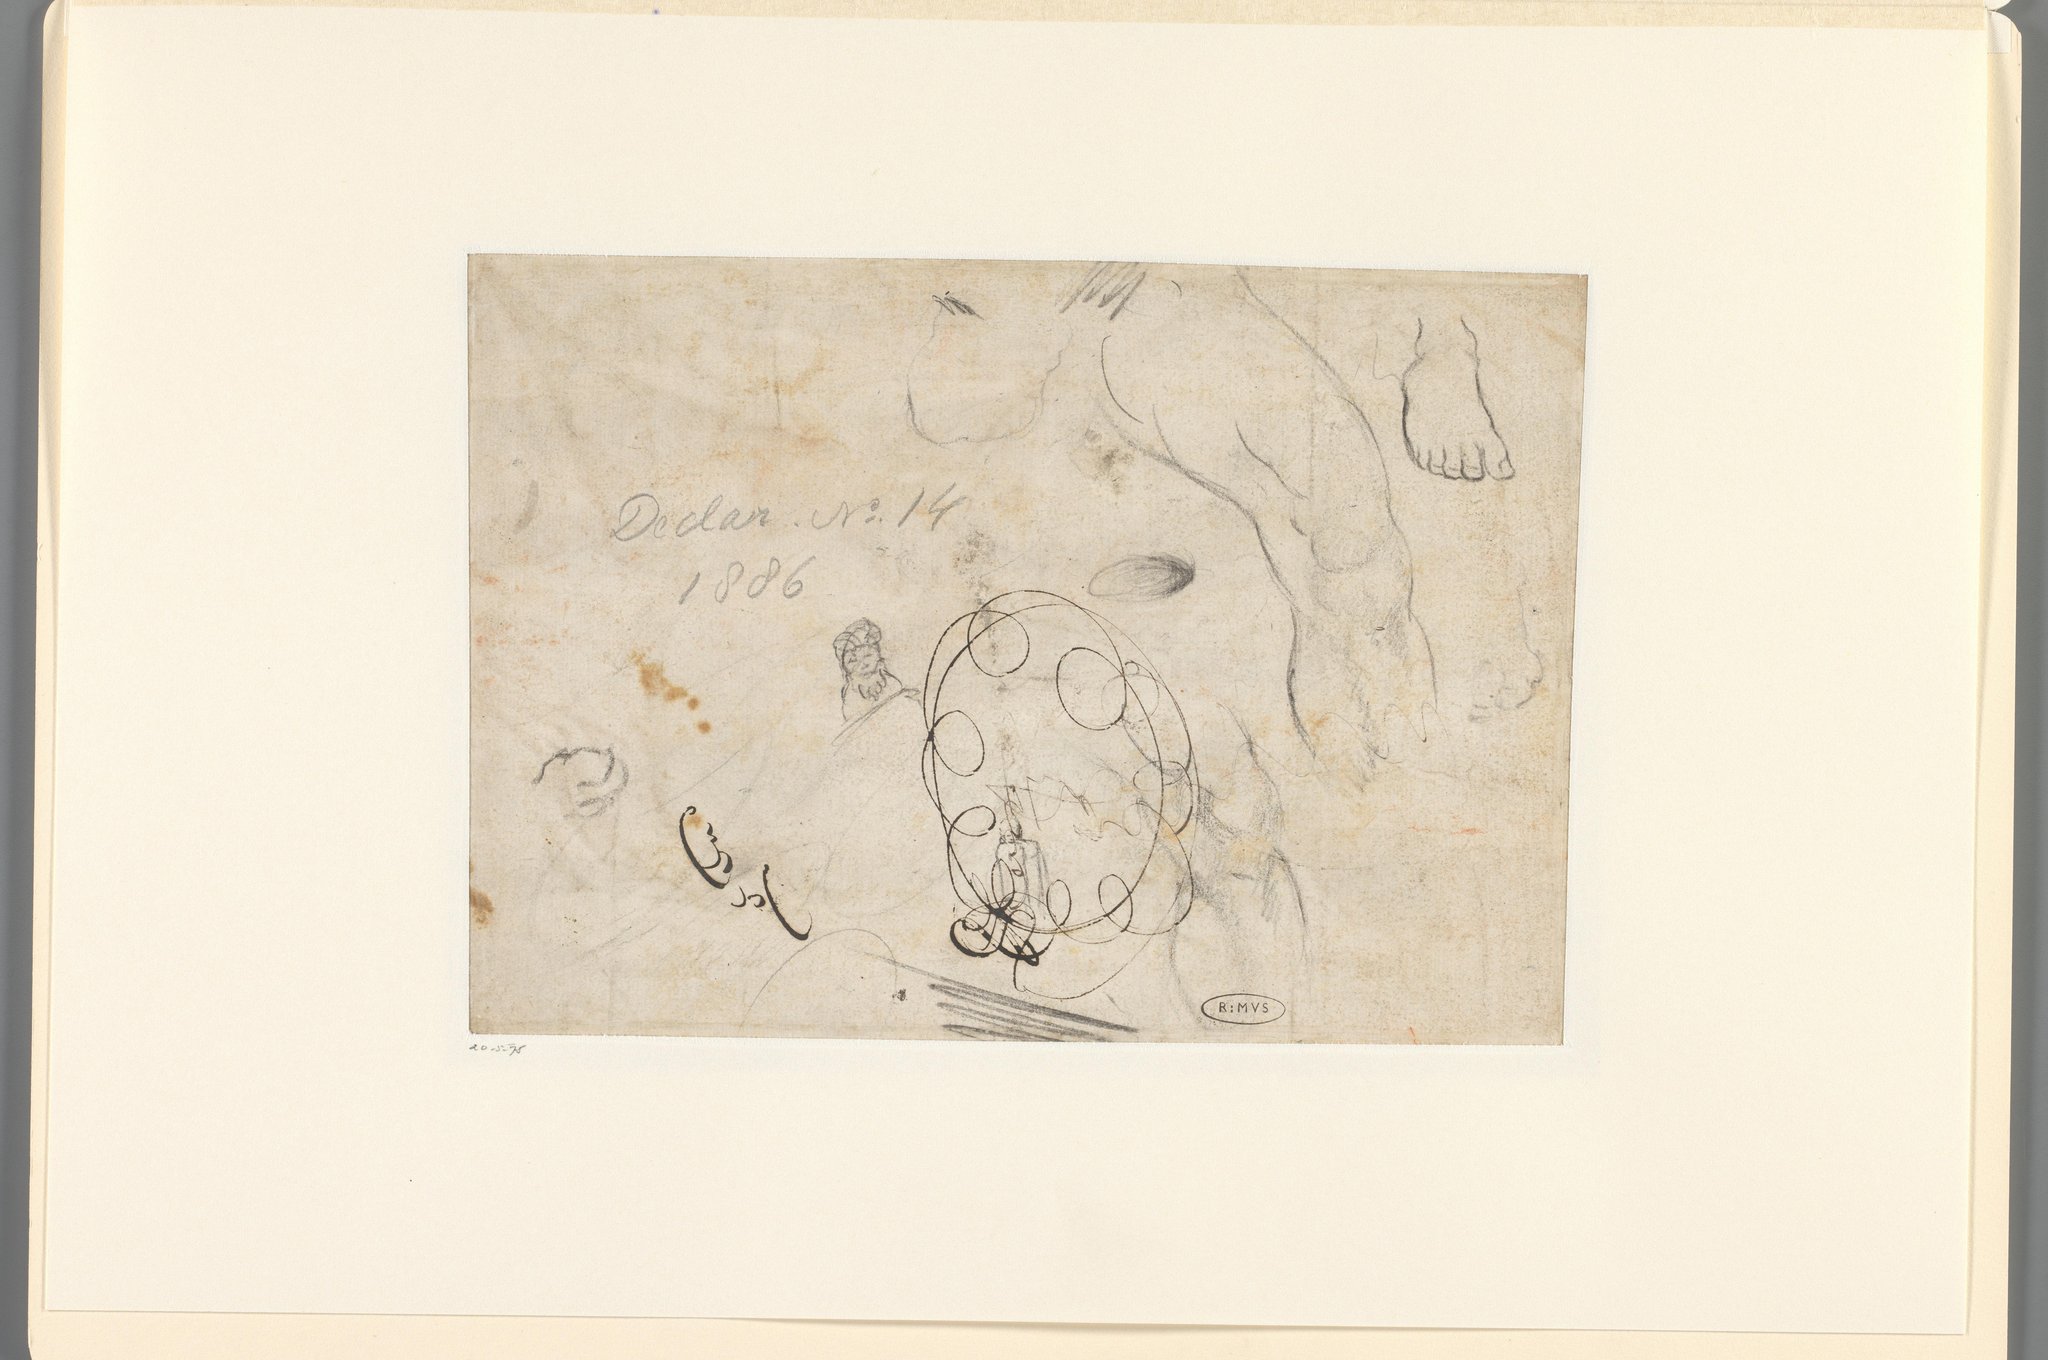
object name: drawing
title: Studies van een been en een voet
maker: Anonymous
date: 1574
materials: chalk, paper